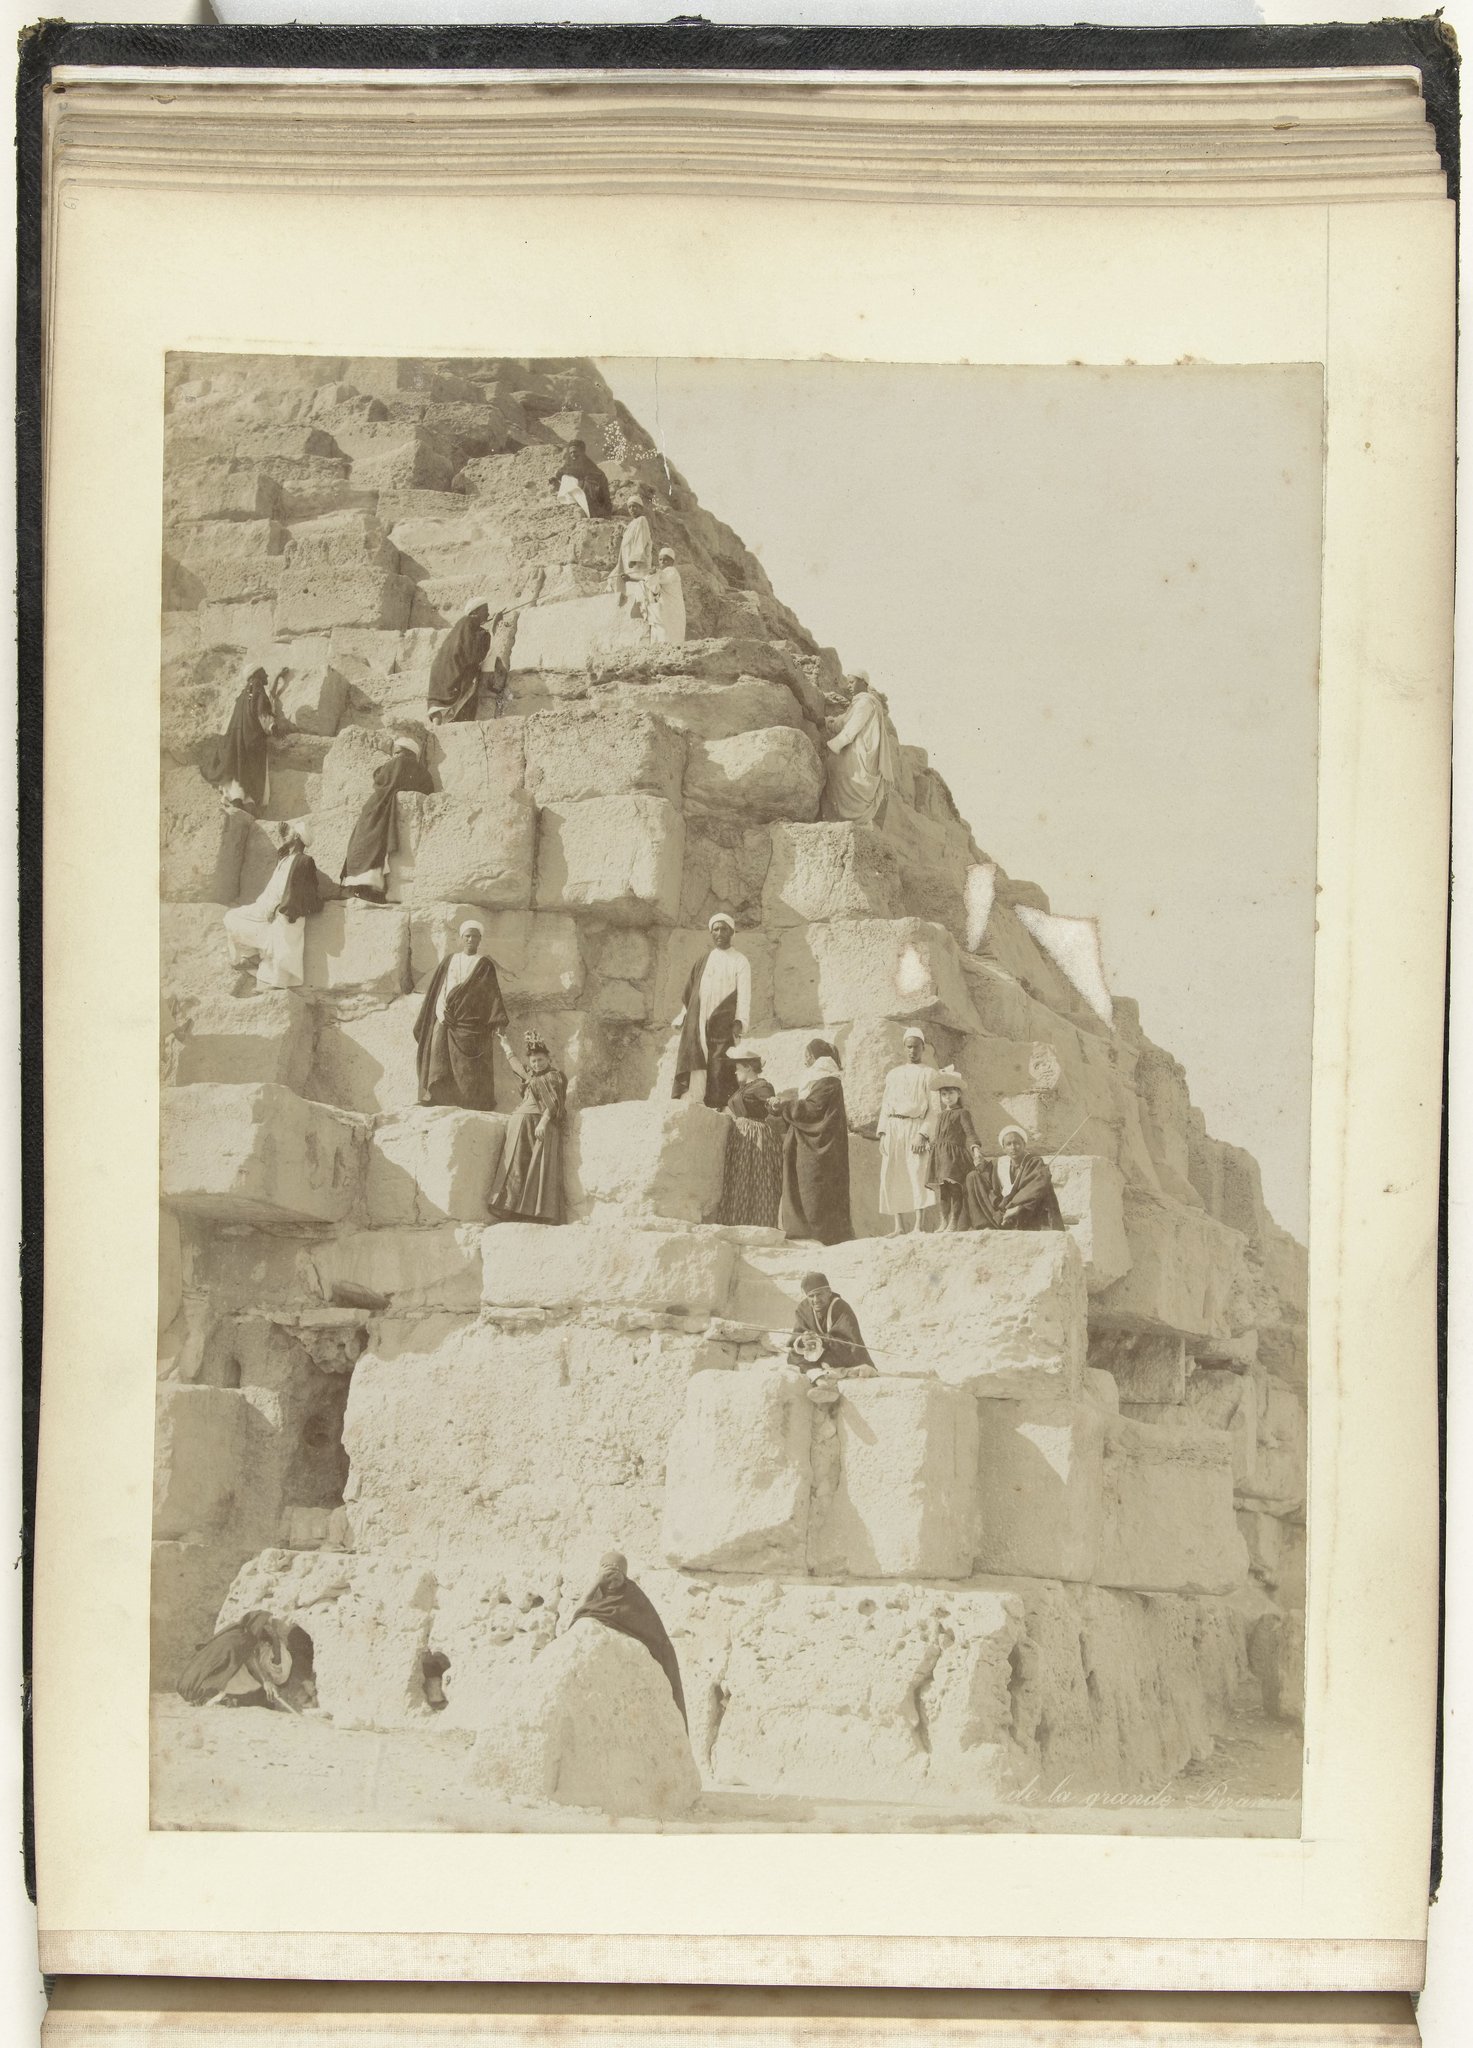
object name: album leaf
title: de la grande pyramid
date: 1870-1900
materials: paper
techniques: albumen print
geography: gizeh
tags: climbing, egyptian pyramids (wonder of the world)